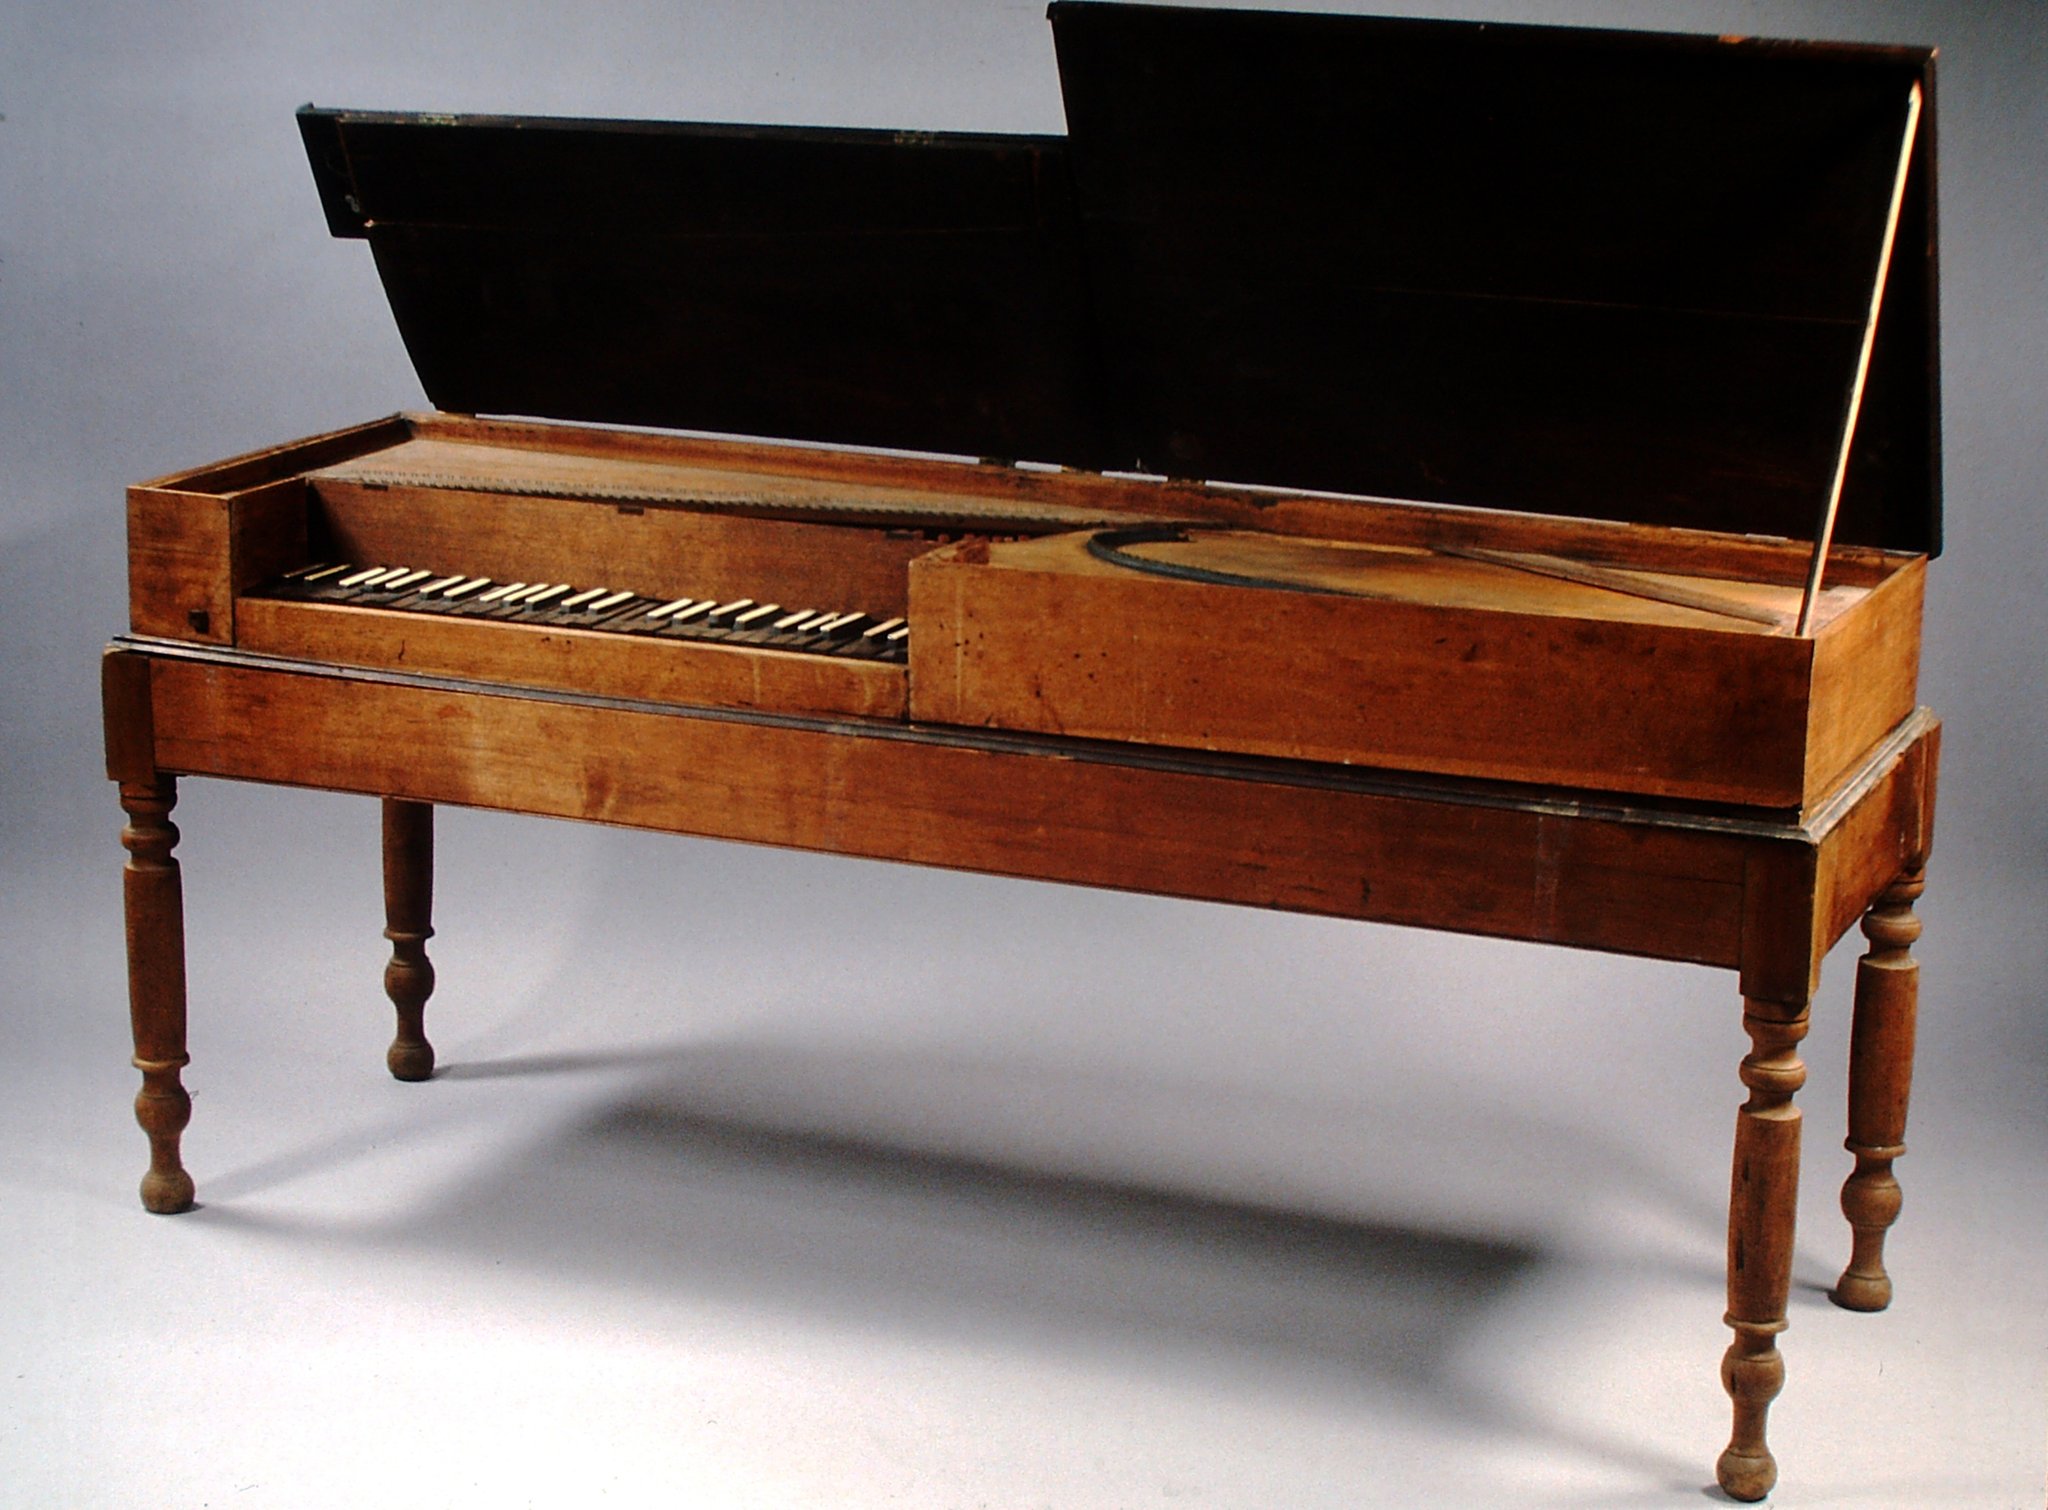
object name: square piano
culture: american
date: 1767-1800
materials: bone, iron, wood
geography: united states